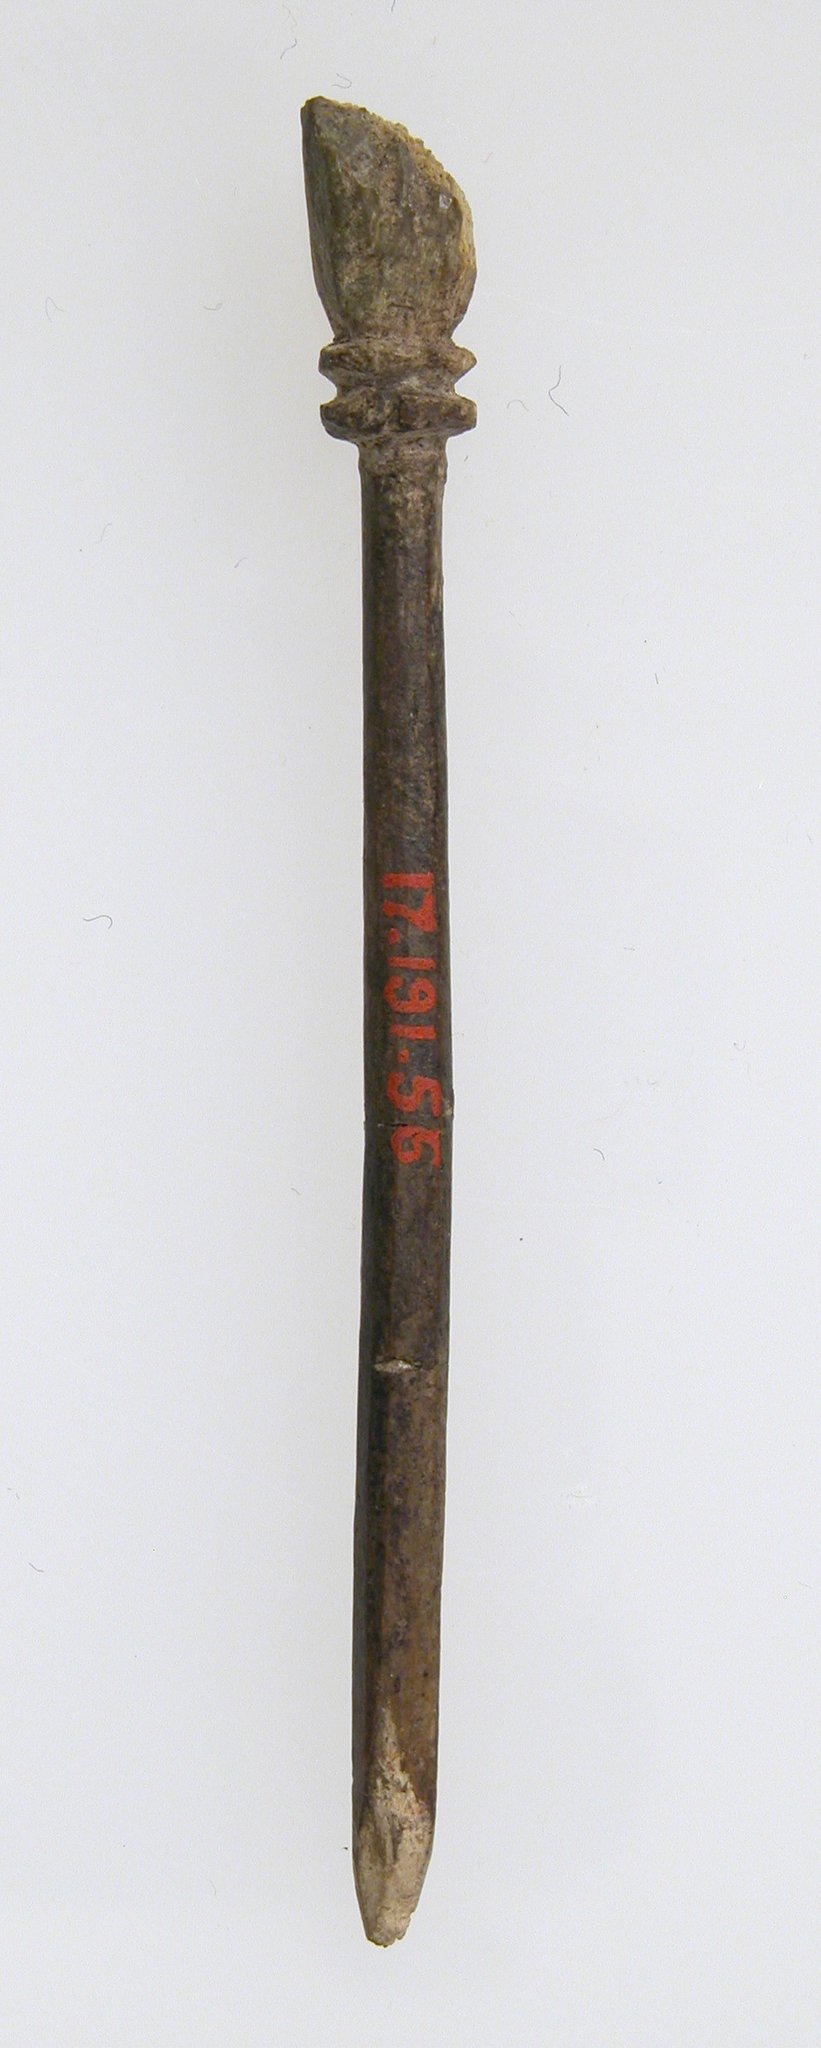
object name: hairpin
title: Hairpin with Terminal Knob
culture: roman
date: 200-500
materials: bone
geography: northern france